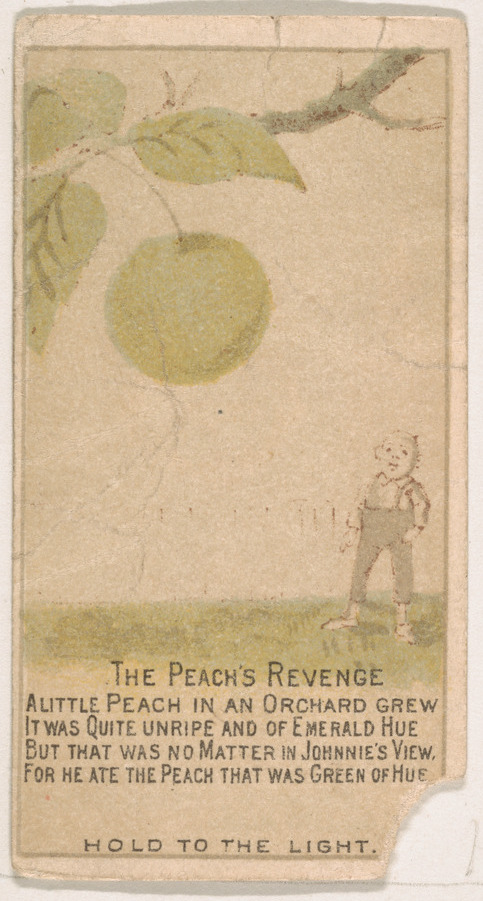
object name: print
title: The Peach's Revenge, from the Magic Changing Cards series (N223) issued by Kinney Tobacco Company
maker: kinney brothers tobacco company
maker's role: publisher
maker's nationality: american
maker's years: 1869-2011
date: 1889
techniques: color lithograph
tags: peaches,boys